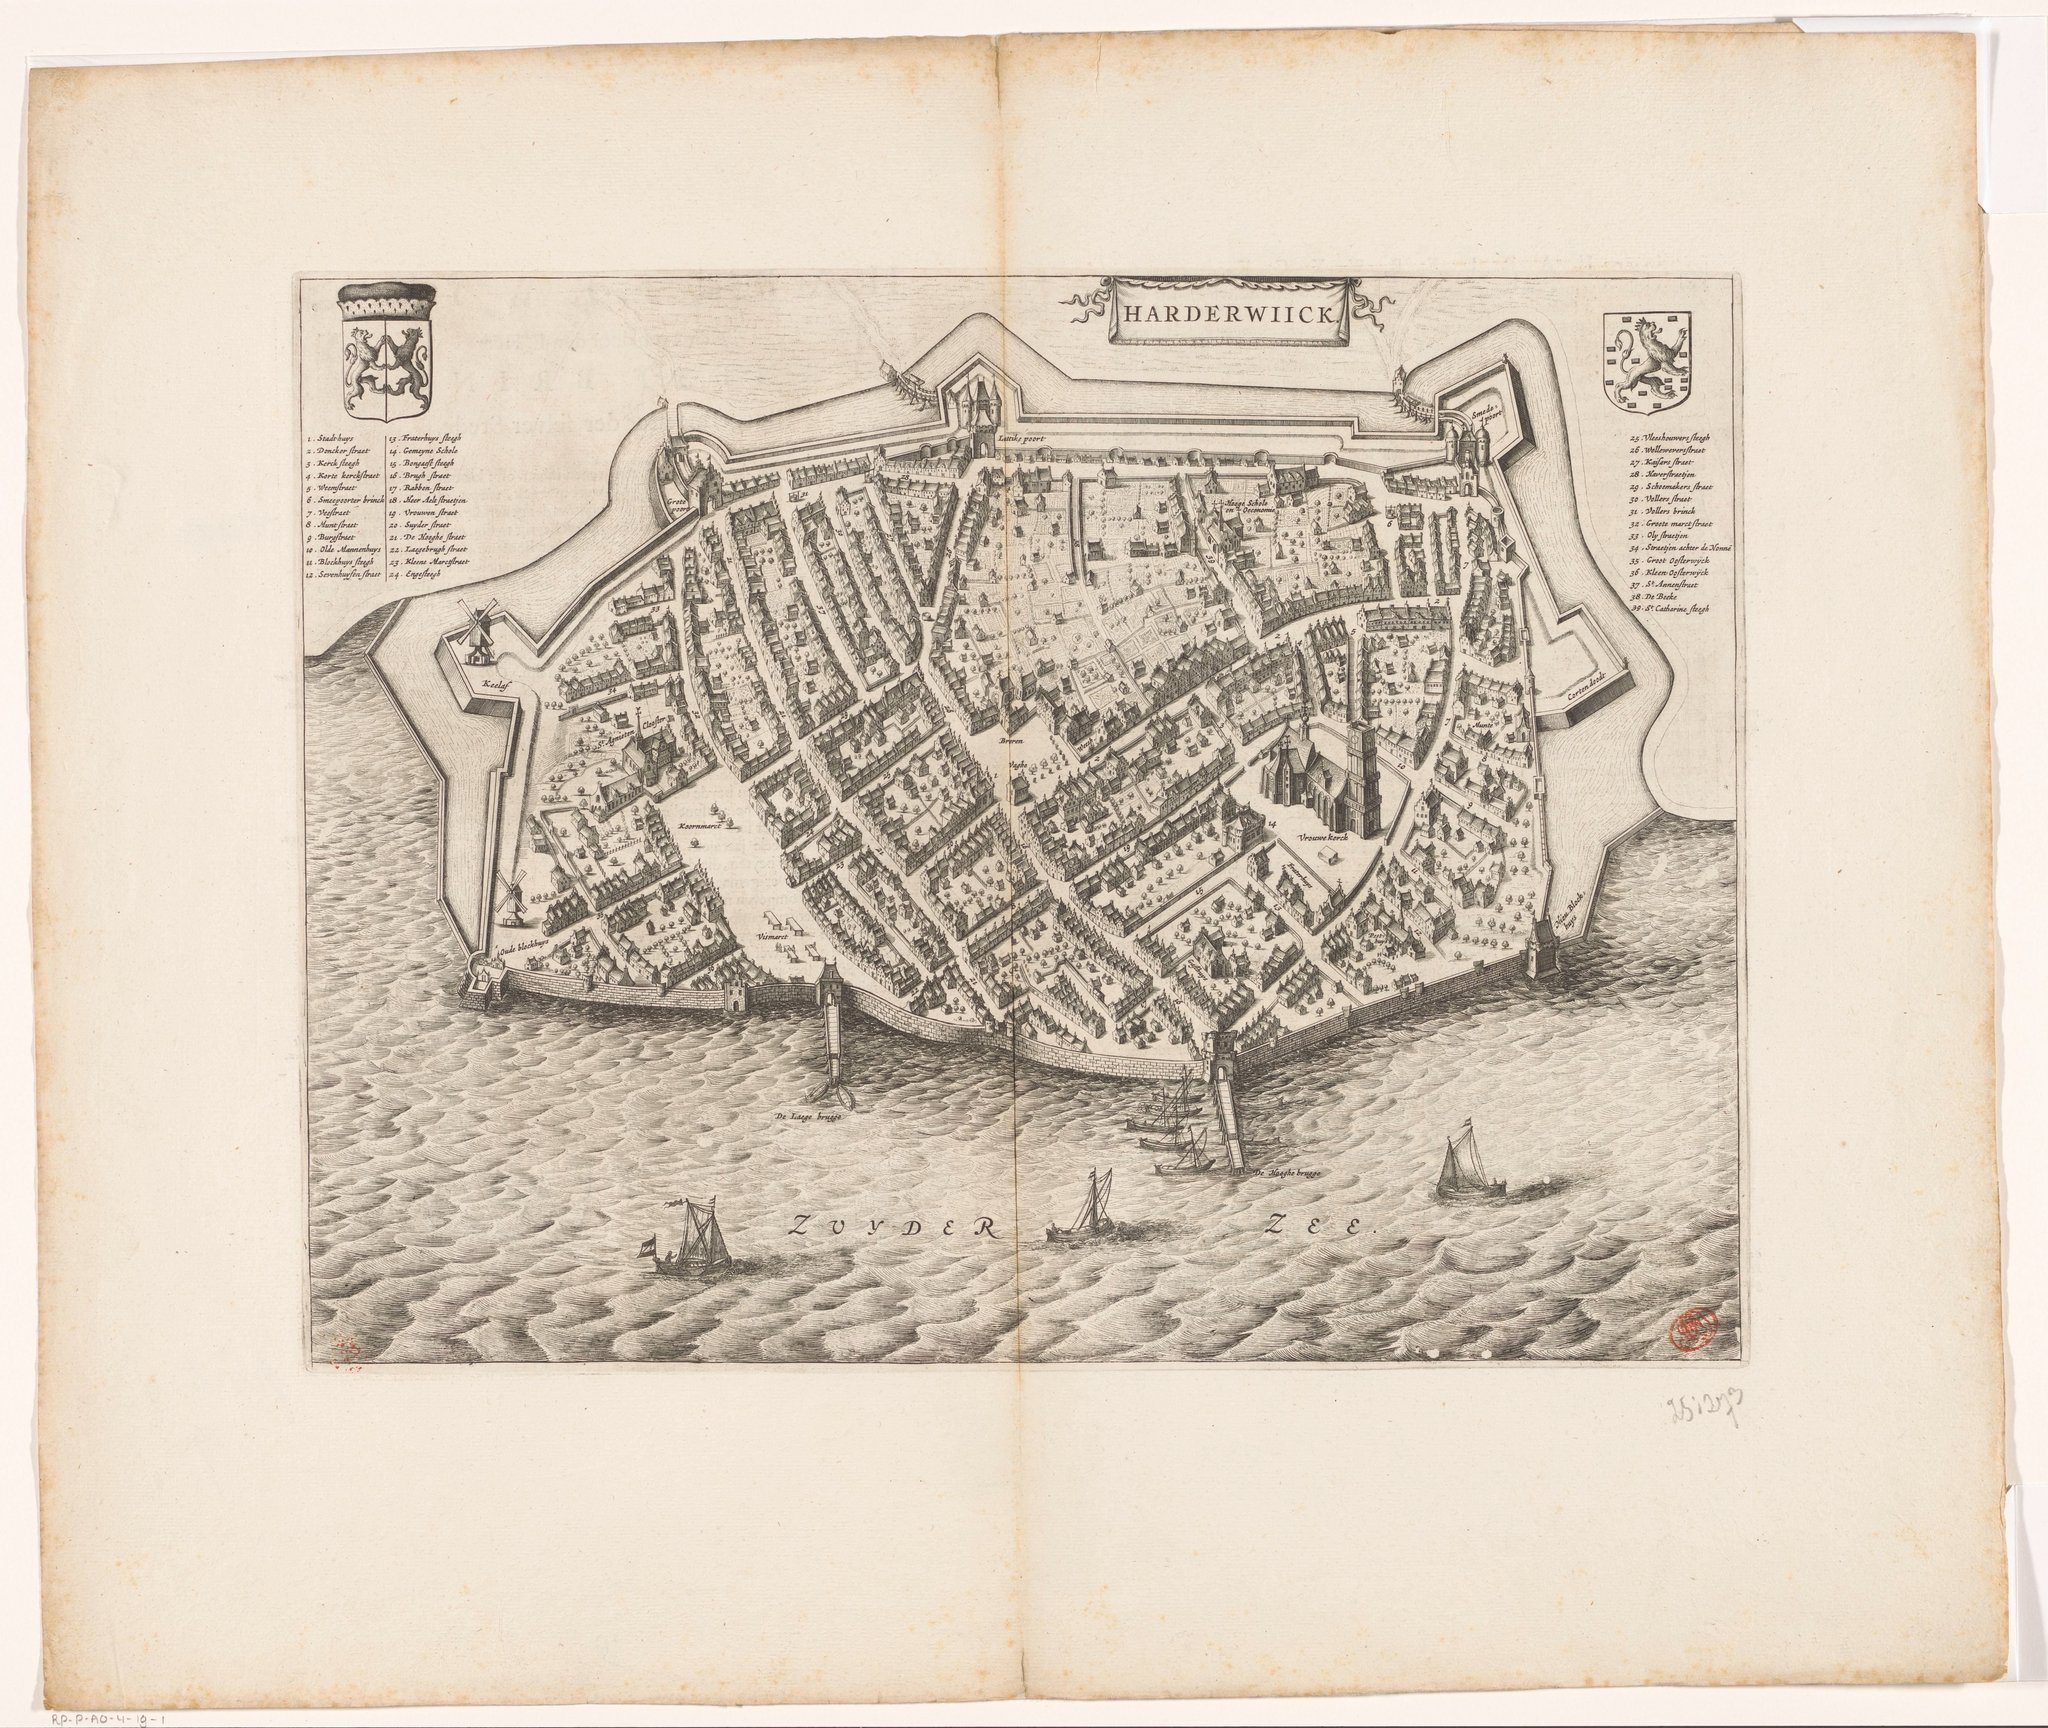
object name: area plan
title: Plattegrond van Harderwijk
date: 1652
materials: paper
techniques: engraving, etching, letterpress printing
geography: amsterdam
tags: coat of arms (as symbol of the state, etc.), maps of cities, gelderland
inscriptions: collector's mark: Lugt 195, collector's mark: Lugt 195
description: Plattegrond in vogelvluchtperspectief. Linksboven het wapen van Gelderland, daaronder een legenda. Rechtsboven het wapen van Harderwijk, daaronder een legenda. Op verso Nederlandse tekst.